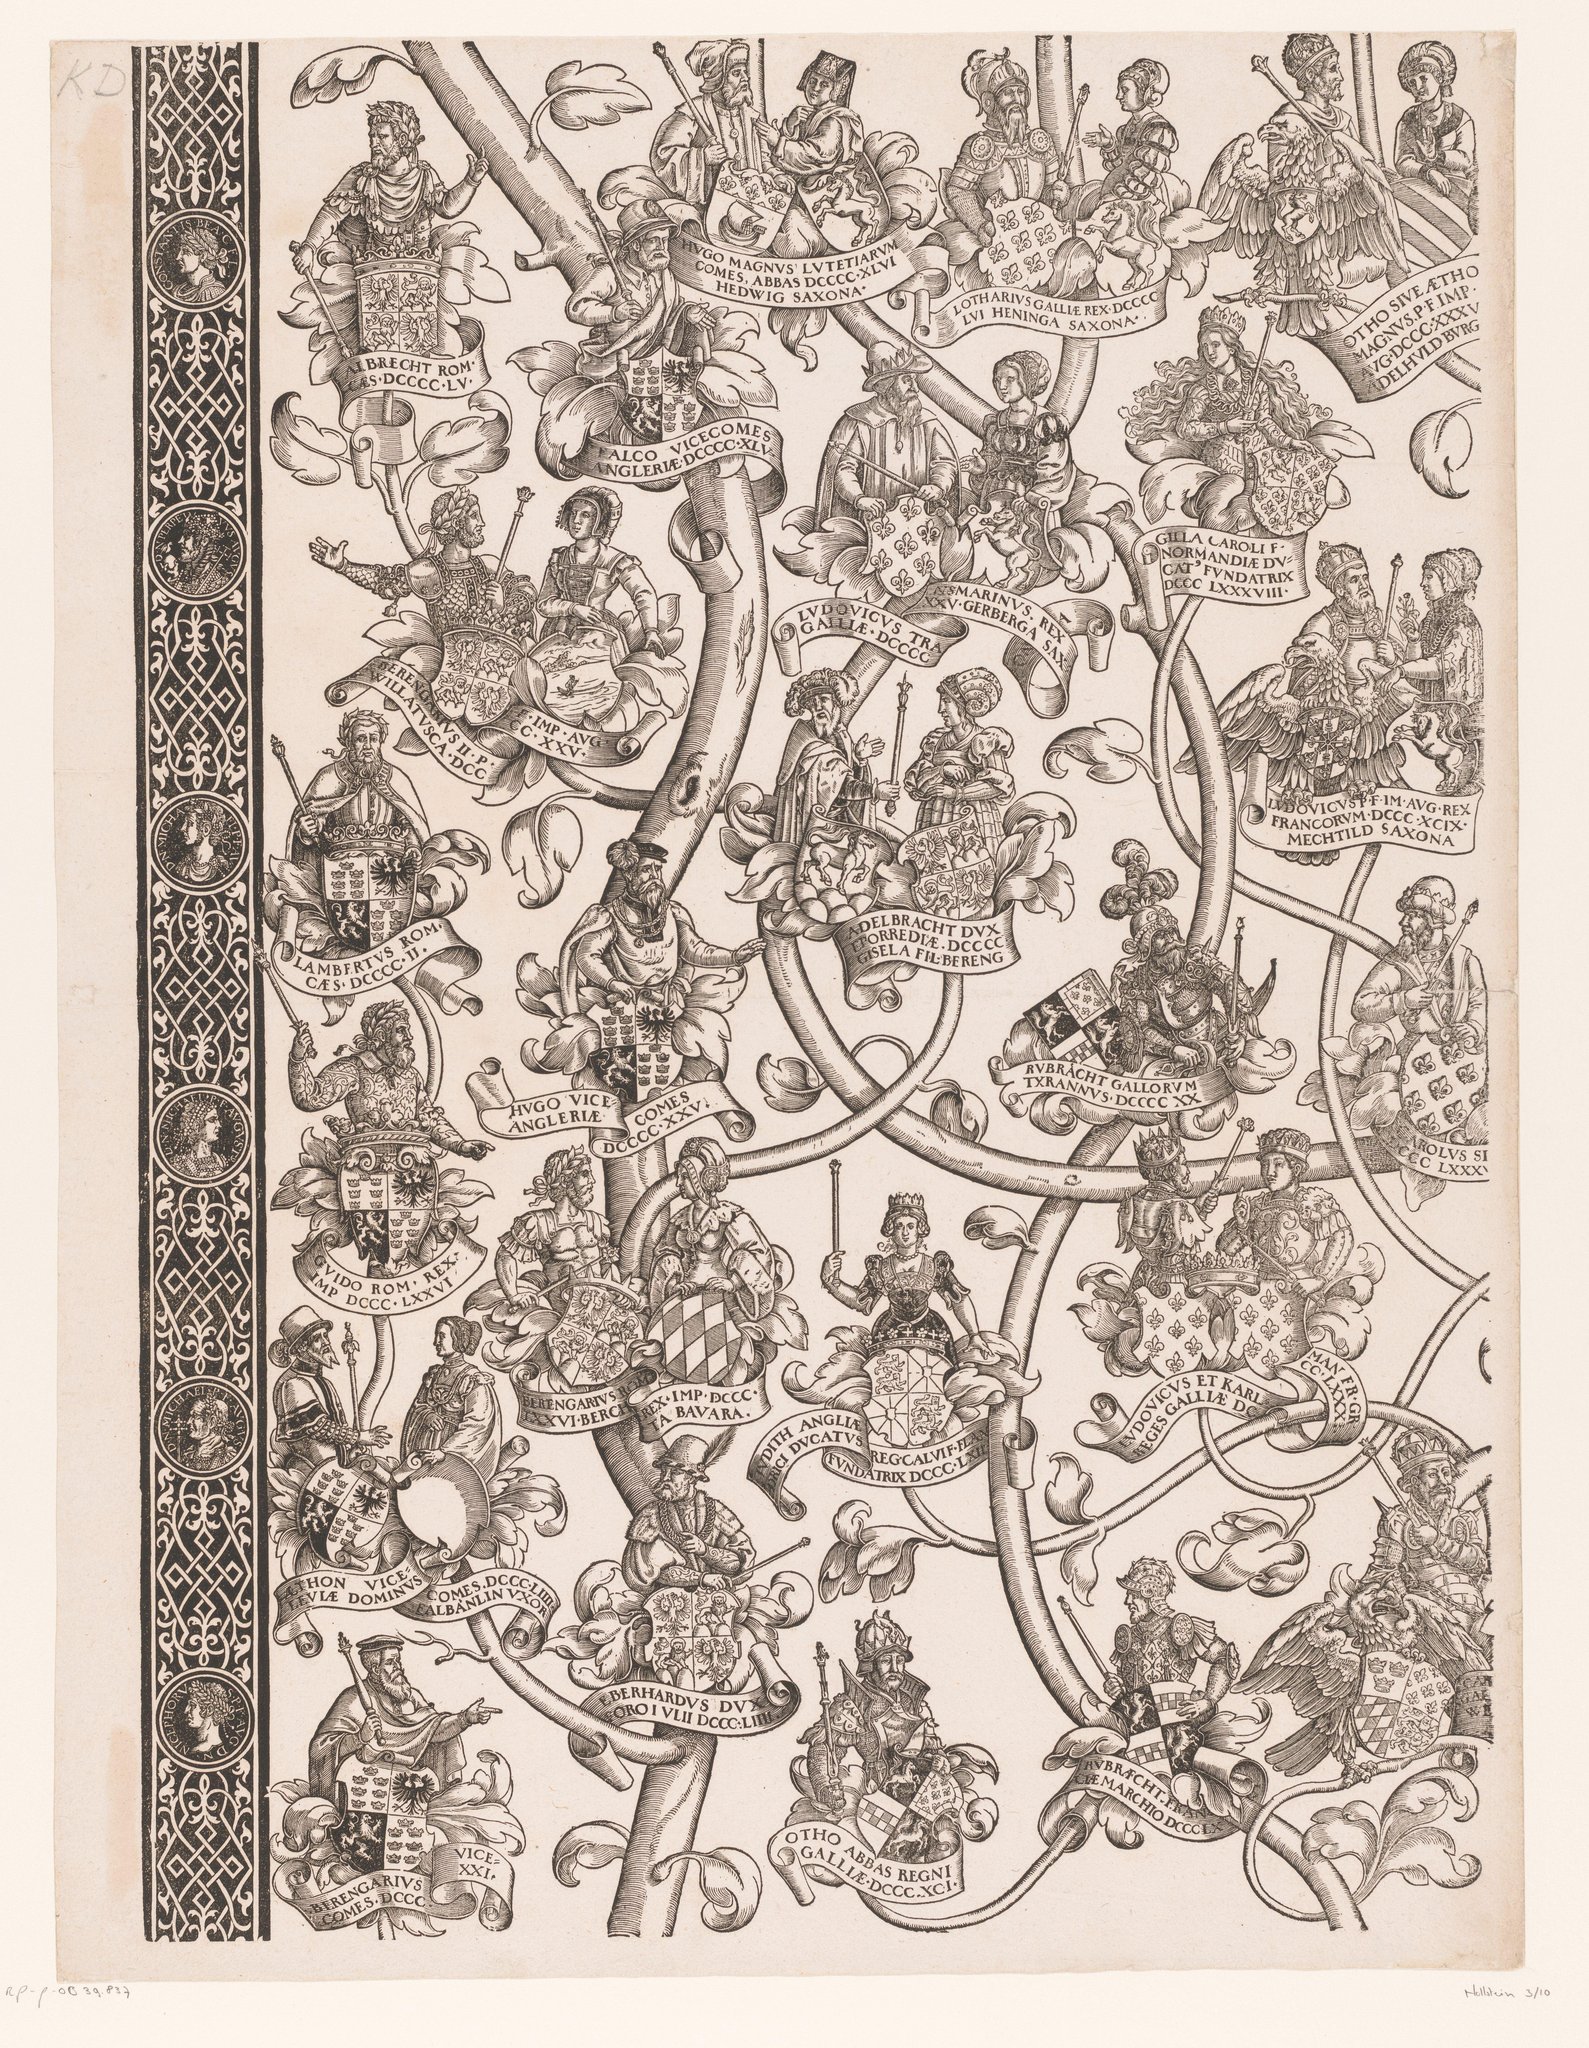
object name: print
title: Stamboom van Frederik en Ottheinrich van Palts-Neuburg (plaat 10)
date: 1535-1594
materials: paper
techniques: letterpress printing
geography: basel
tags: earl, family lineage, pedigree, genealogical tree or table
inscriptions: collector's mark: Lugt 240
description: Blad 10 van een stamboom bestaande uit 21 bladen, gedrukt van 42 blokken.